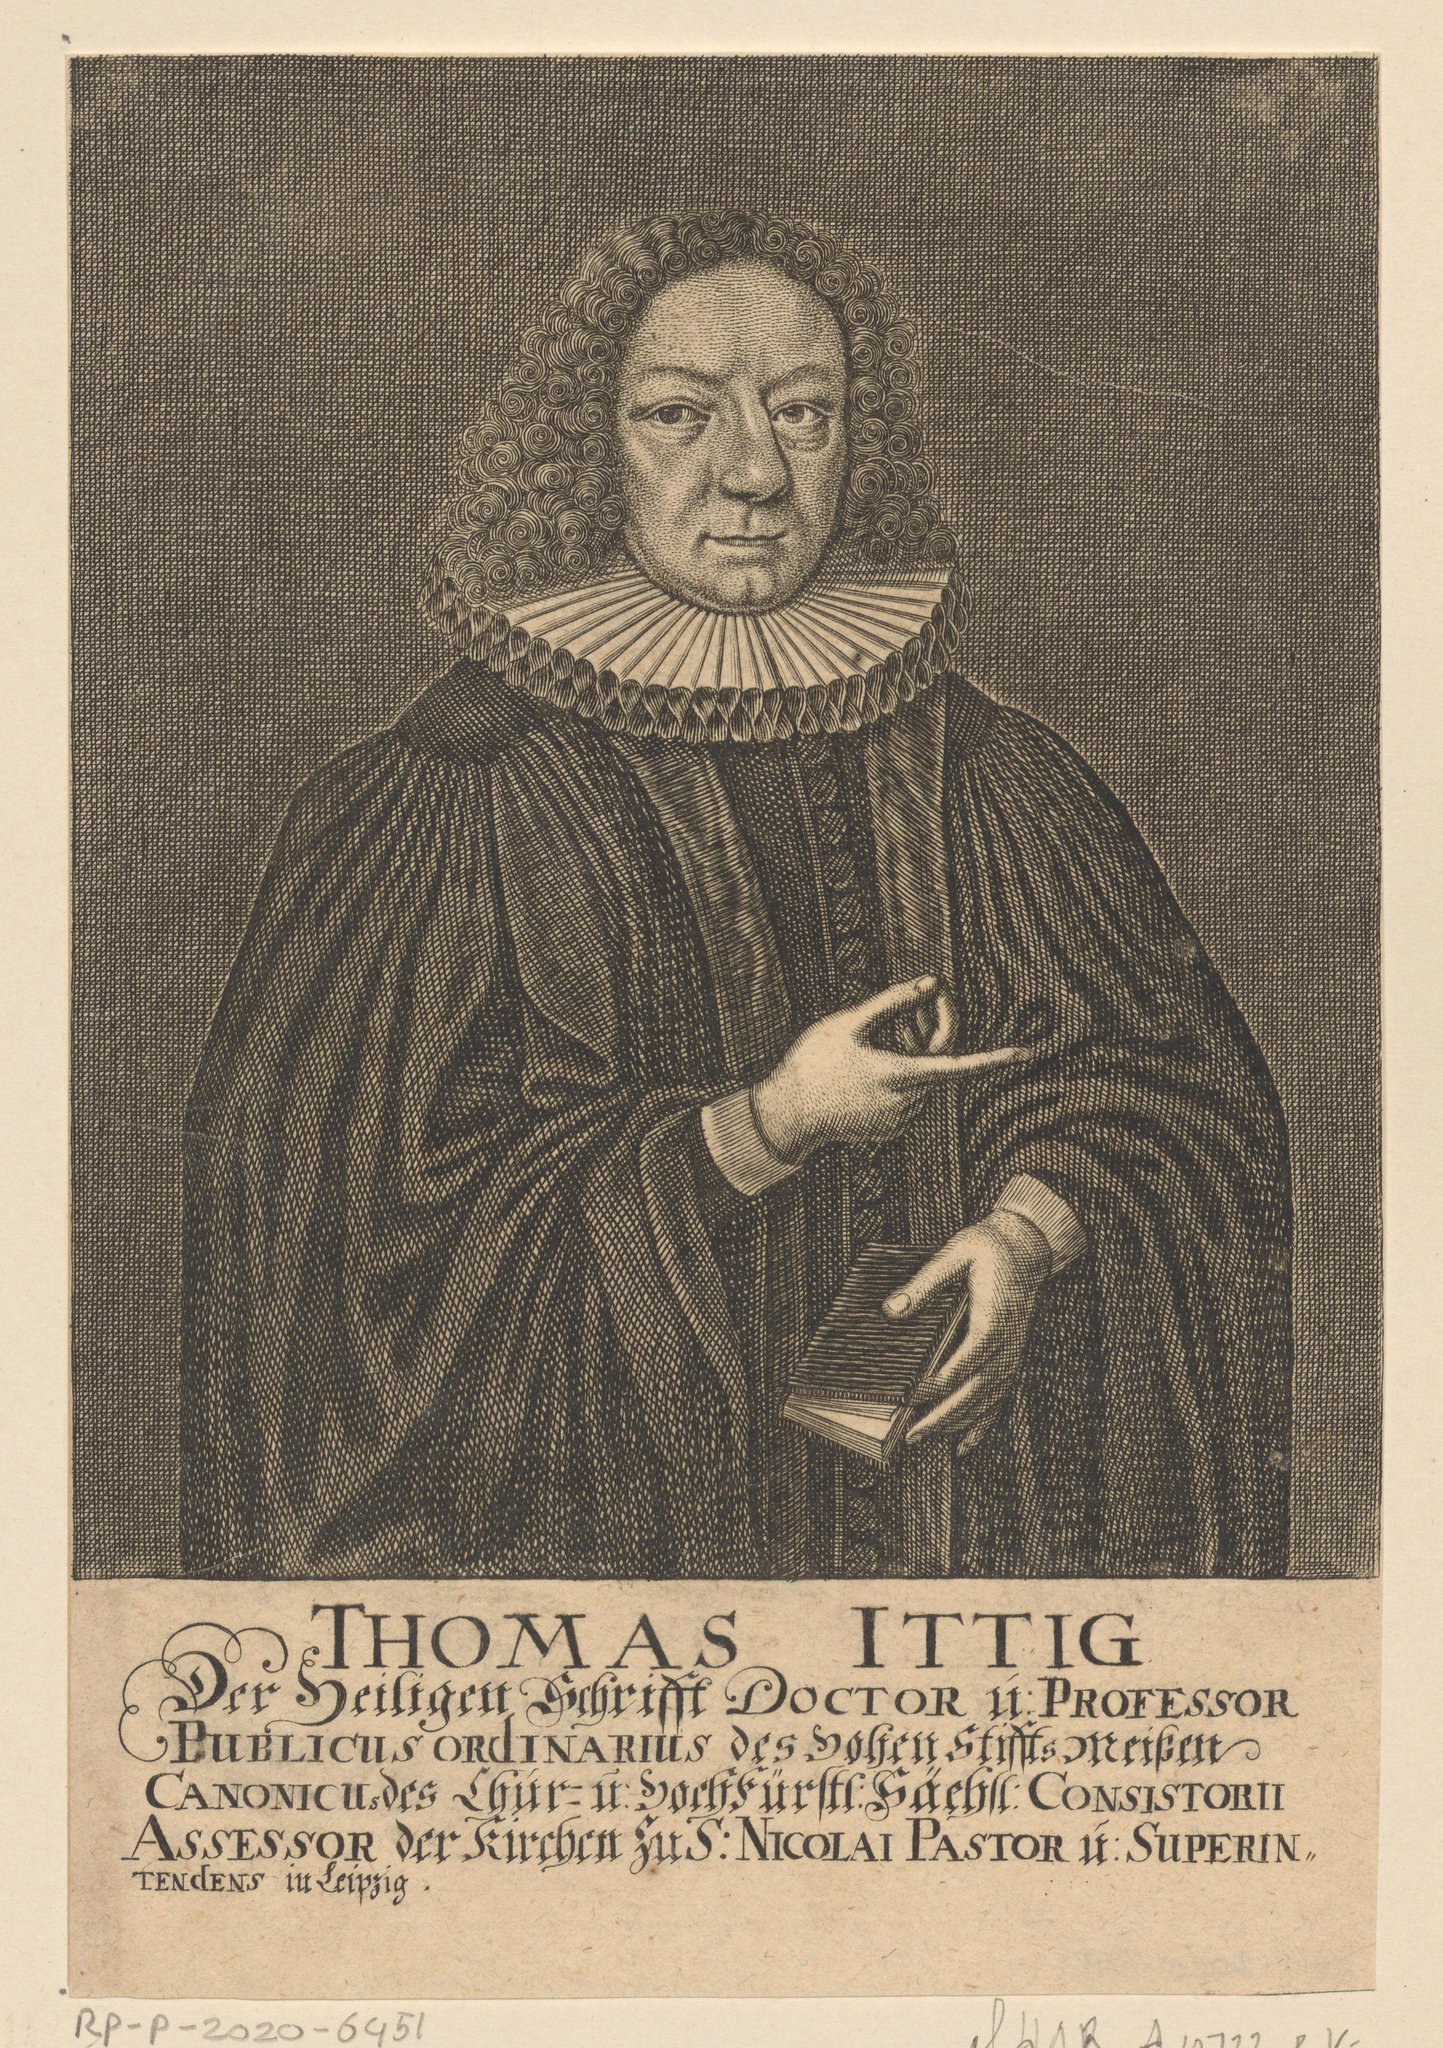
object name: print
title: Portret van Thomas Ittig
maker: Anonymous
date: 1699-1750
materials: paper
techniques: engraving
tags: thomas ittig, theologian, historical persons, book